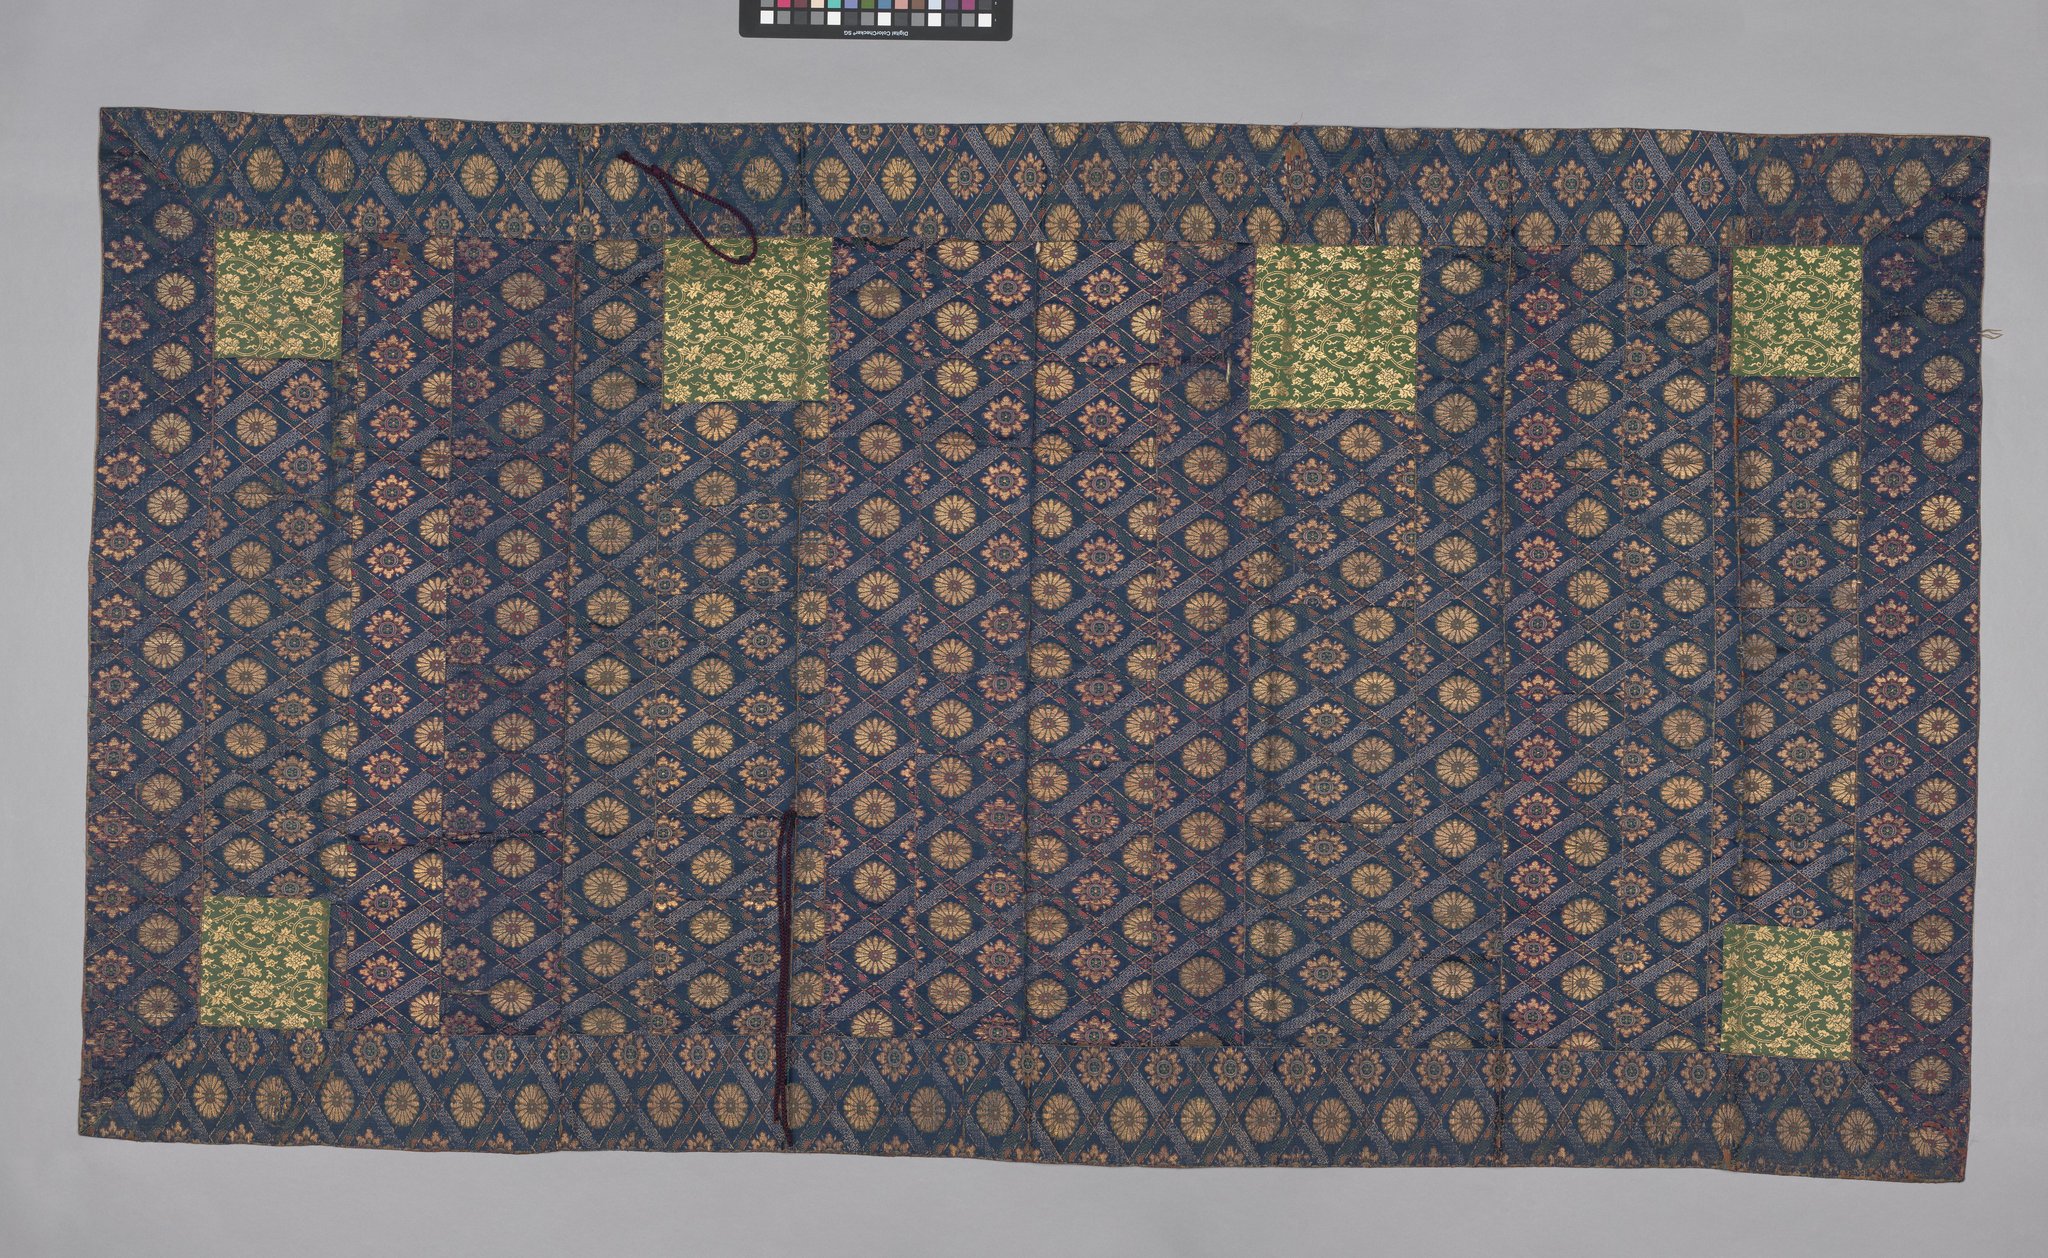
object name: robe, priest's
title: Priest's Robe (Shichijō)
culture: japanese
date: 1596-1615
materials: metal thread, silk